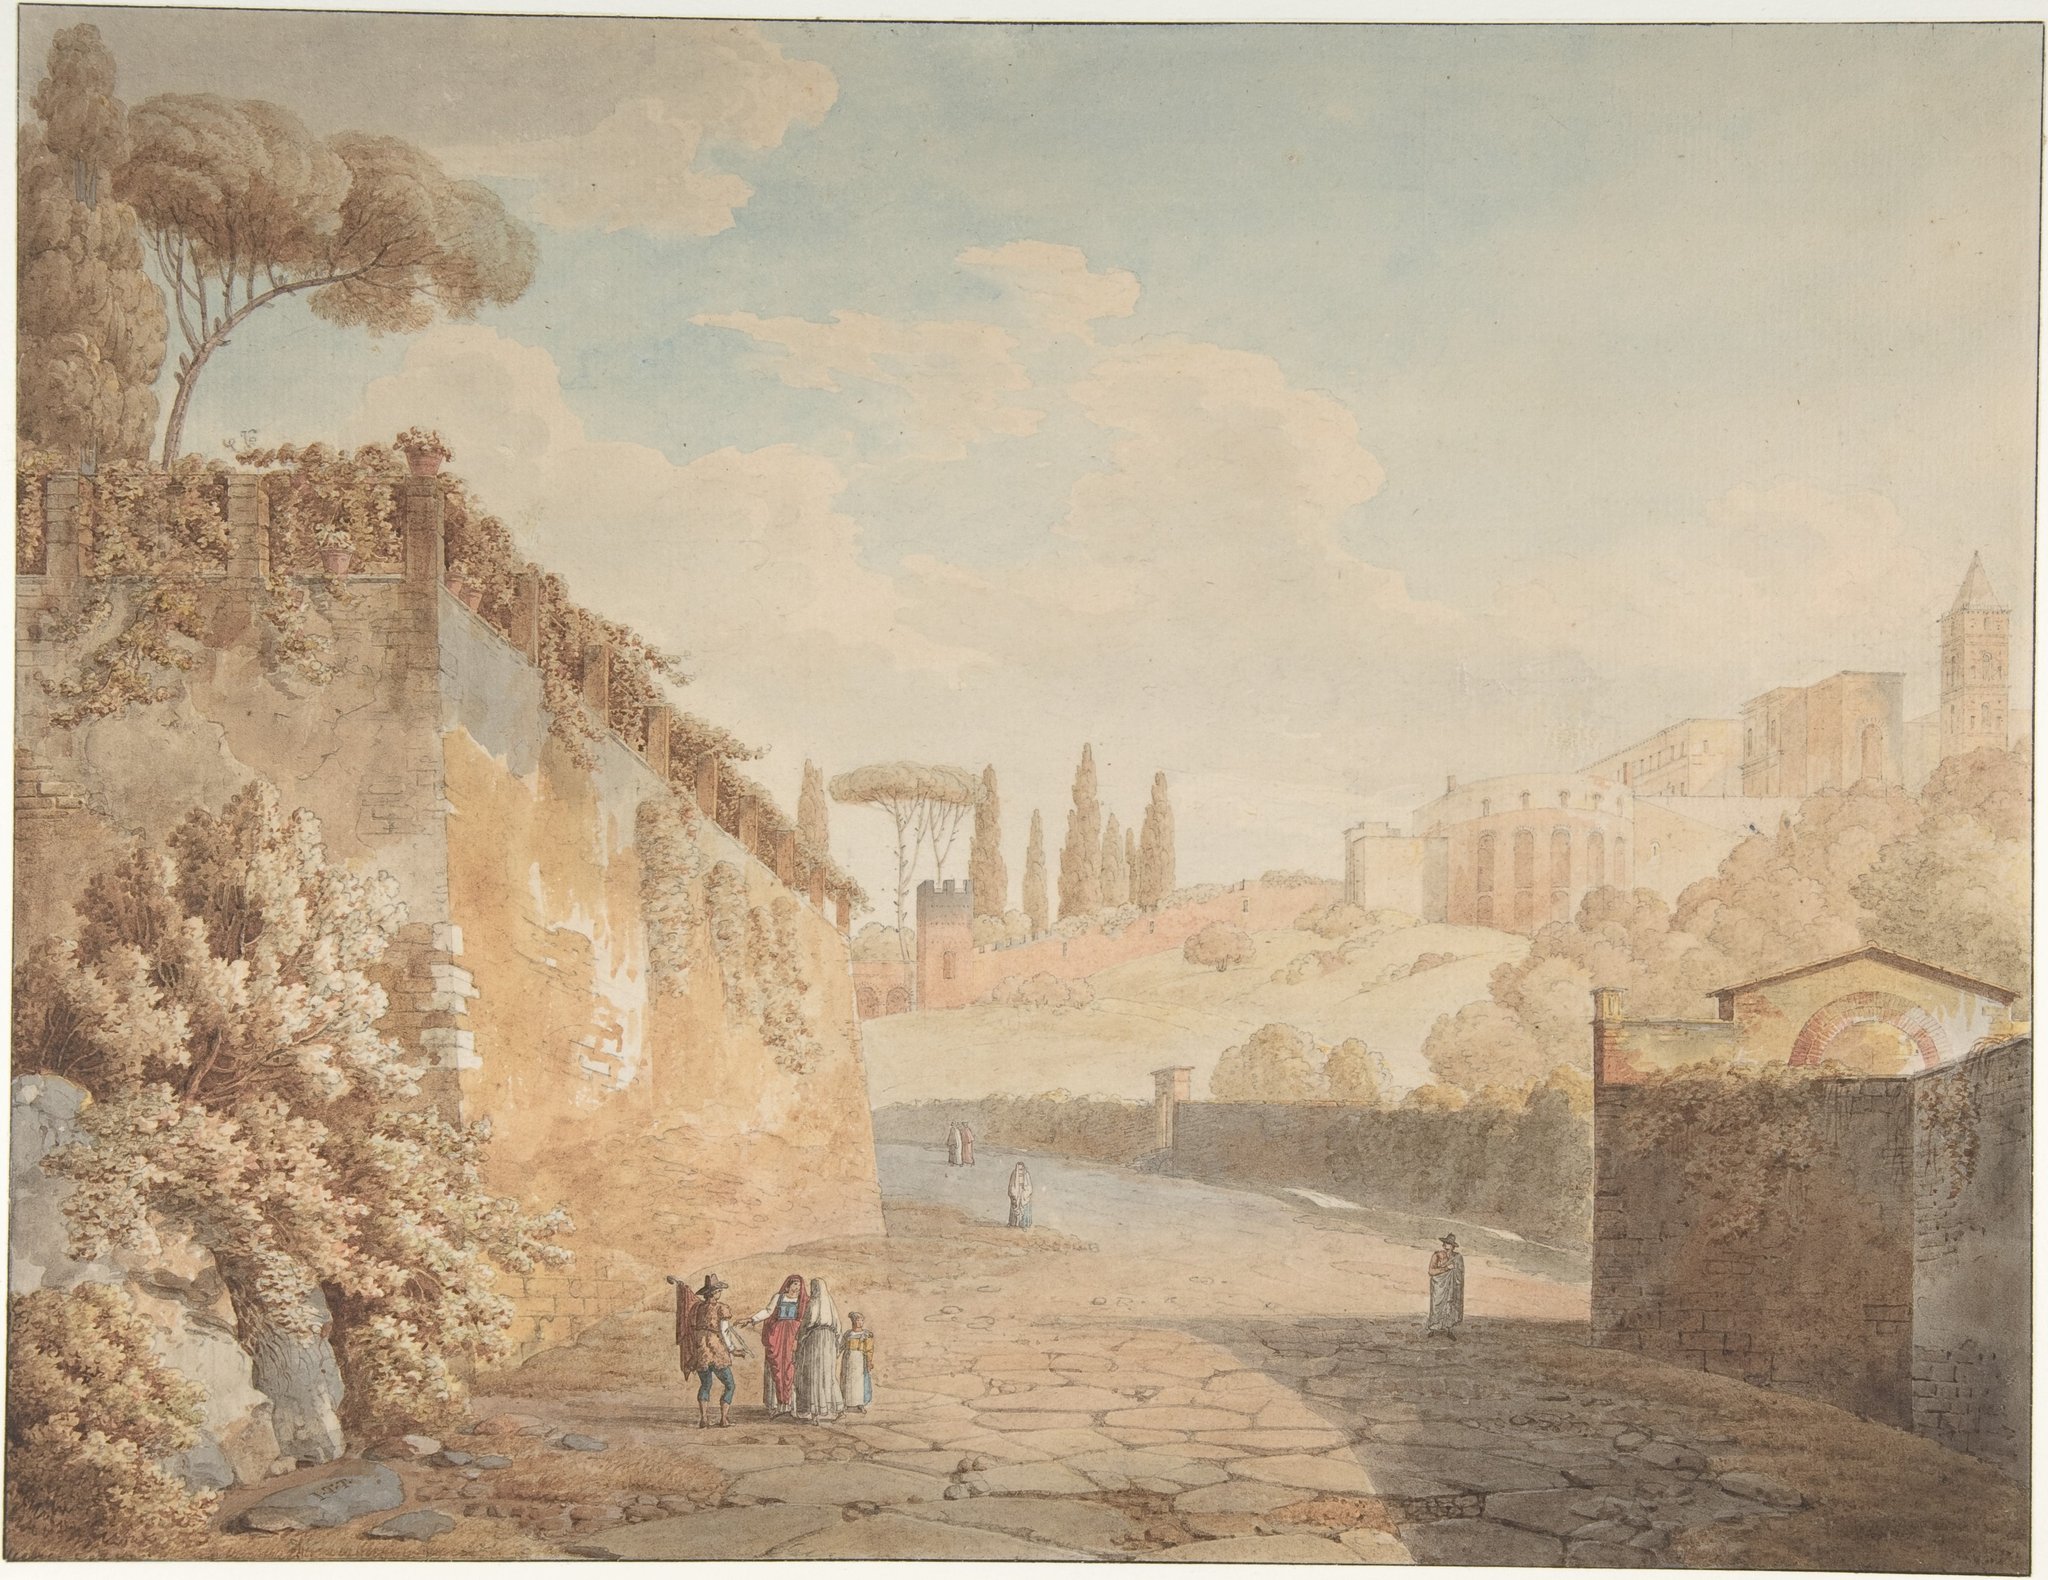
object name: drawing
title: A Road below the Villa d'Este at Tivoli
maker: jean thomas thibault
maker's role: artist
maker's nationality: french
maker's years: 1757-1826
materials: chalk, graphite, ink, watercolor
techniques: pen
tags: buildings,roads,men,women,trees